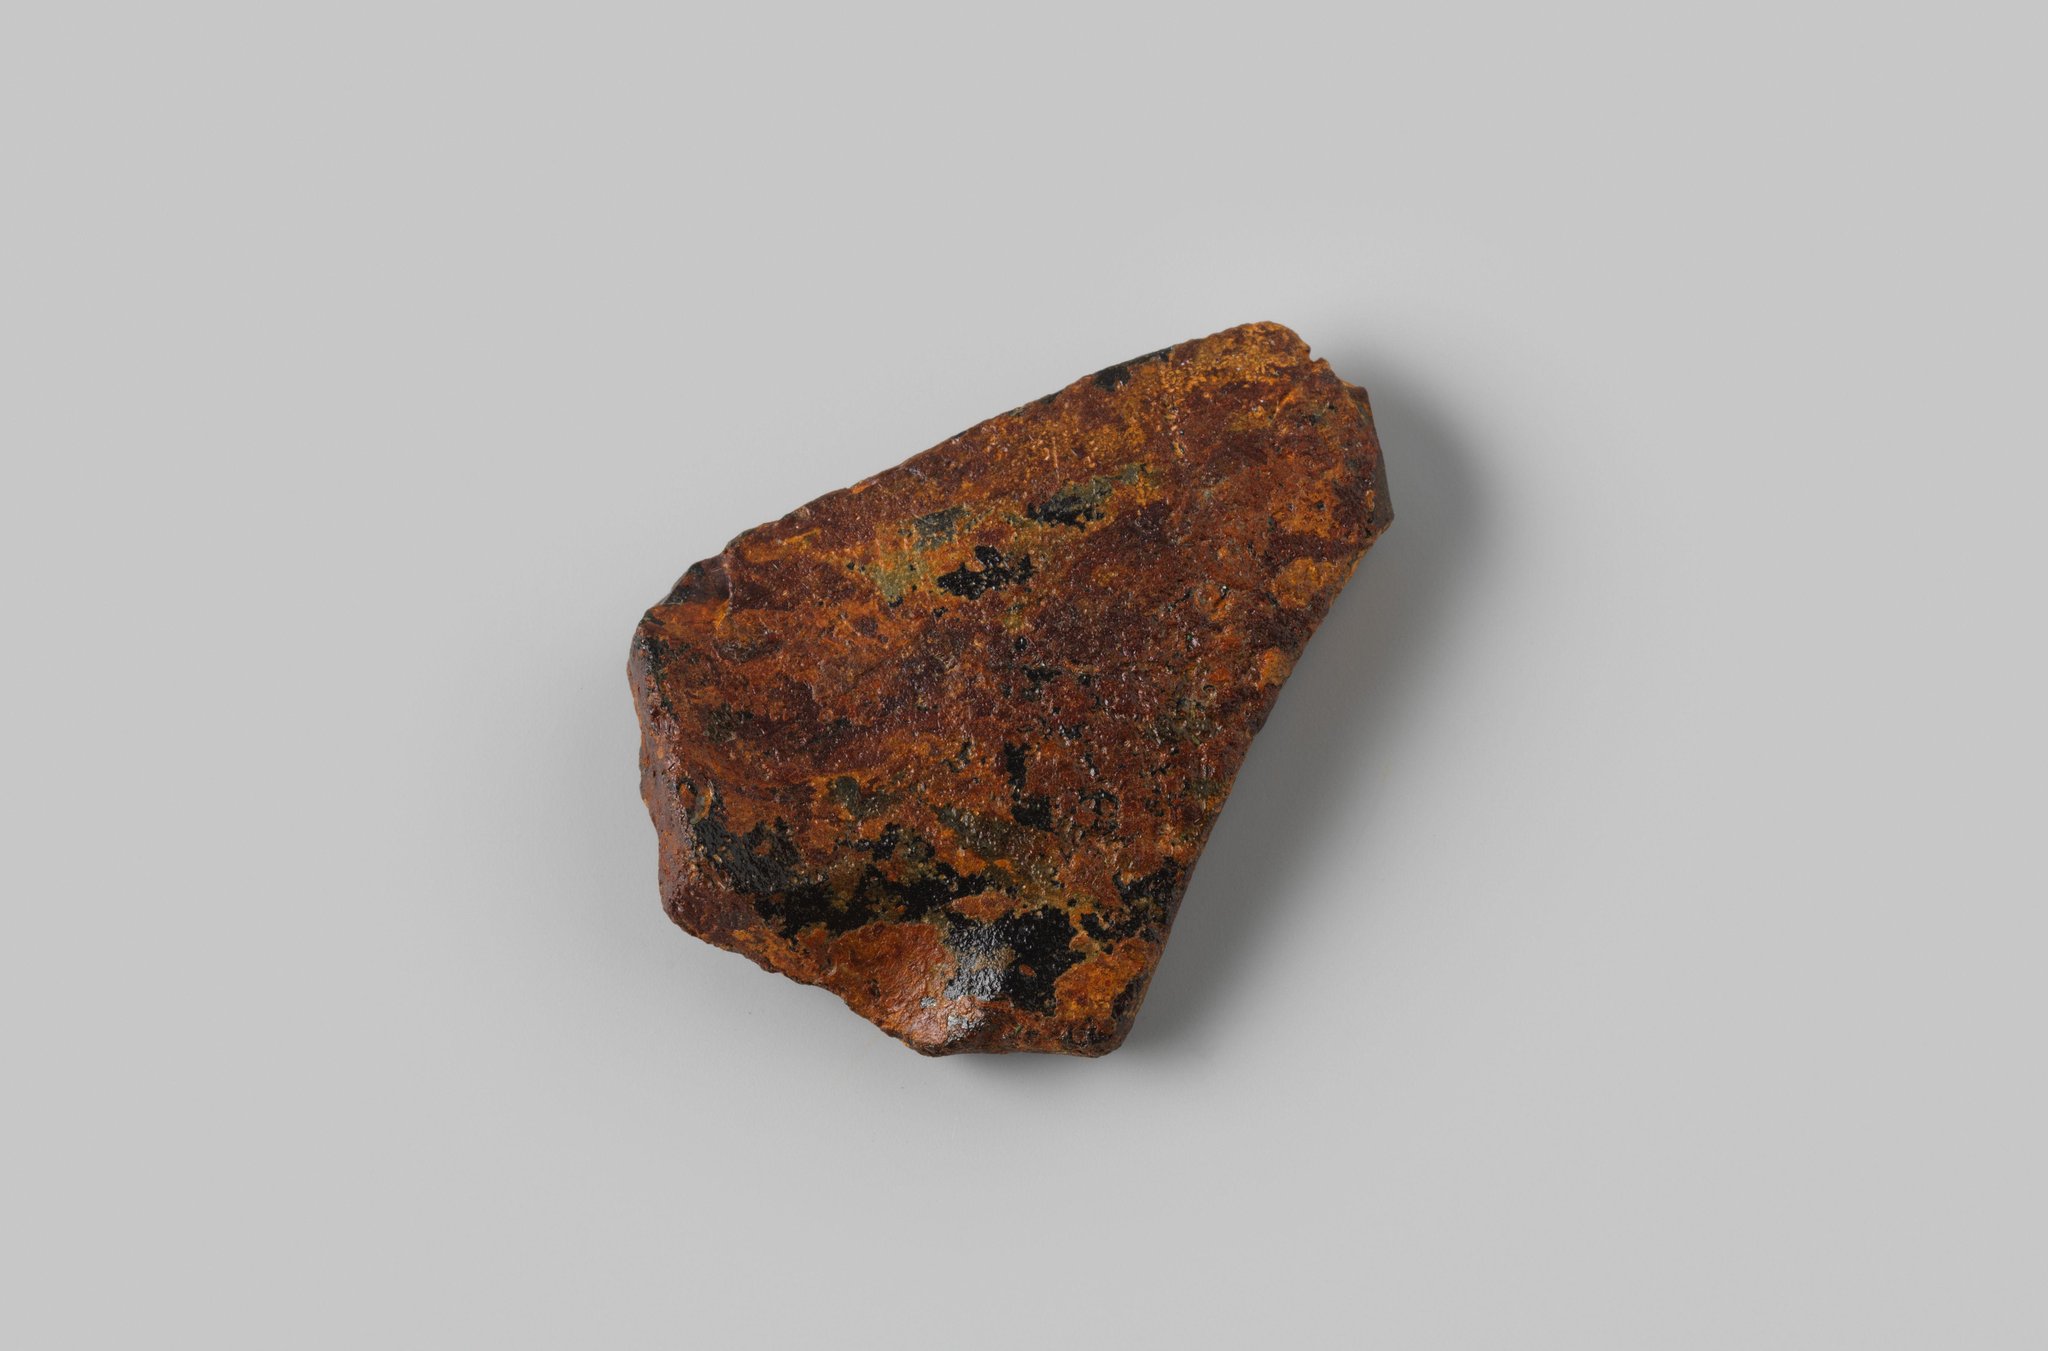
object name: sherd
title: Scherf van een wijnfles uit het wrak van de Oost-Indiëvaarder Hollandia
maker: Anonymous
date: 1700-1743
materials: glass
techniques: green glass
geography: netherlands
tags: verenigde oostindische compagnie, hollandia (schip), annet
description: Typologically not identifiable, base, fragm.